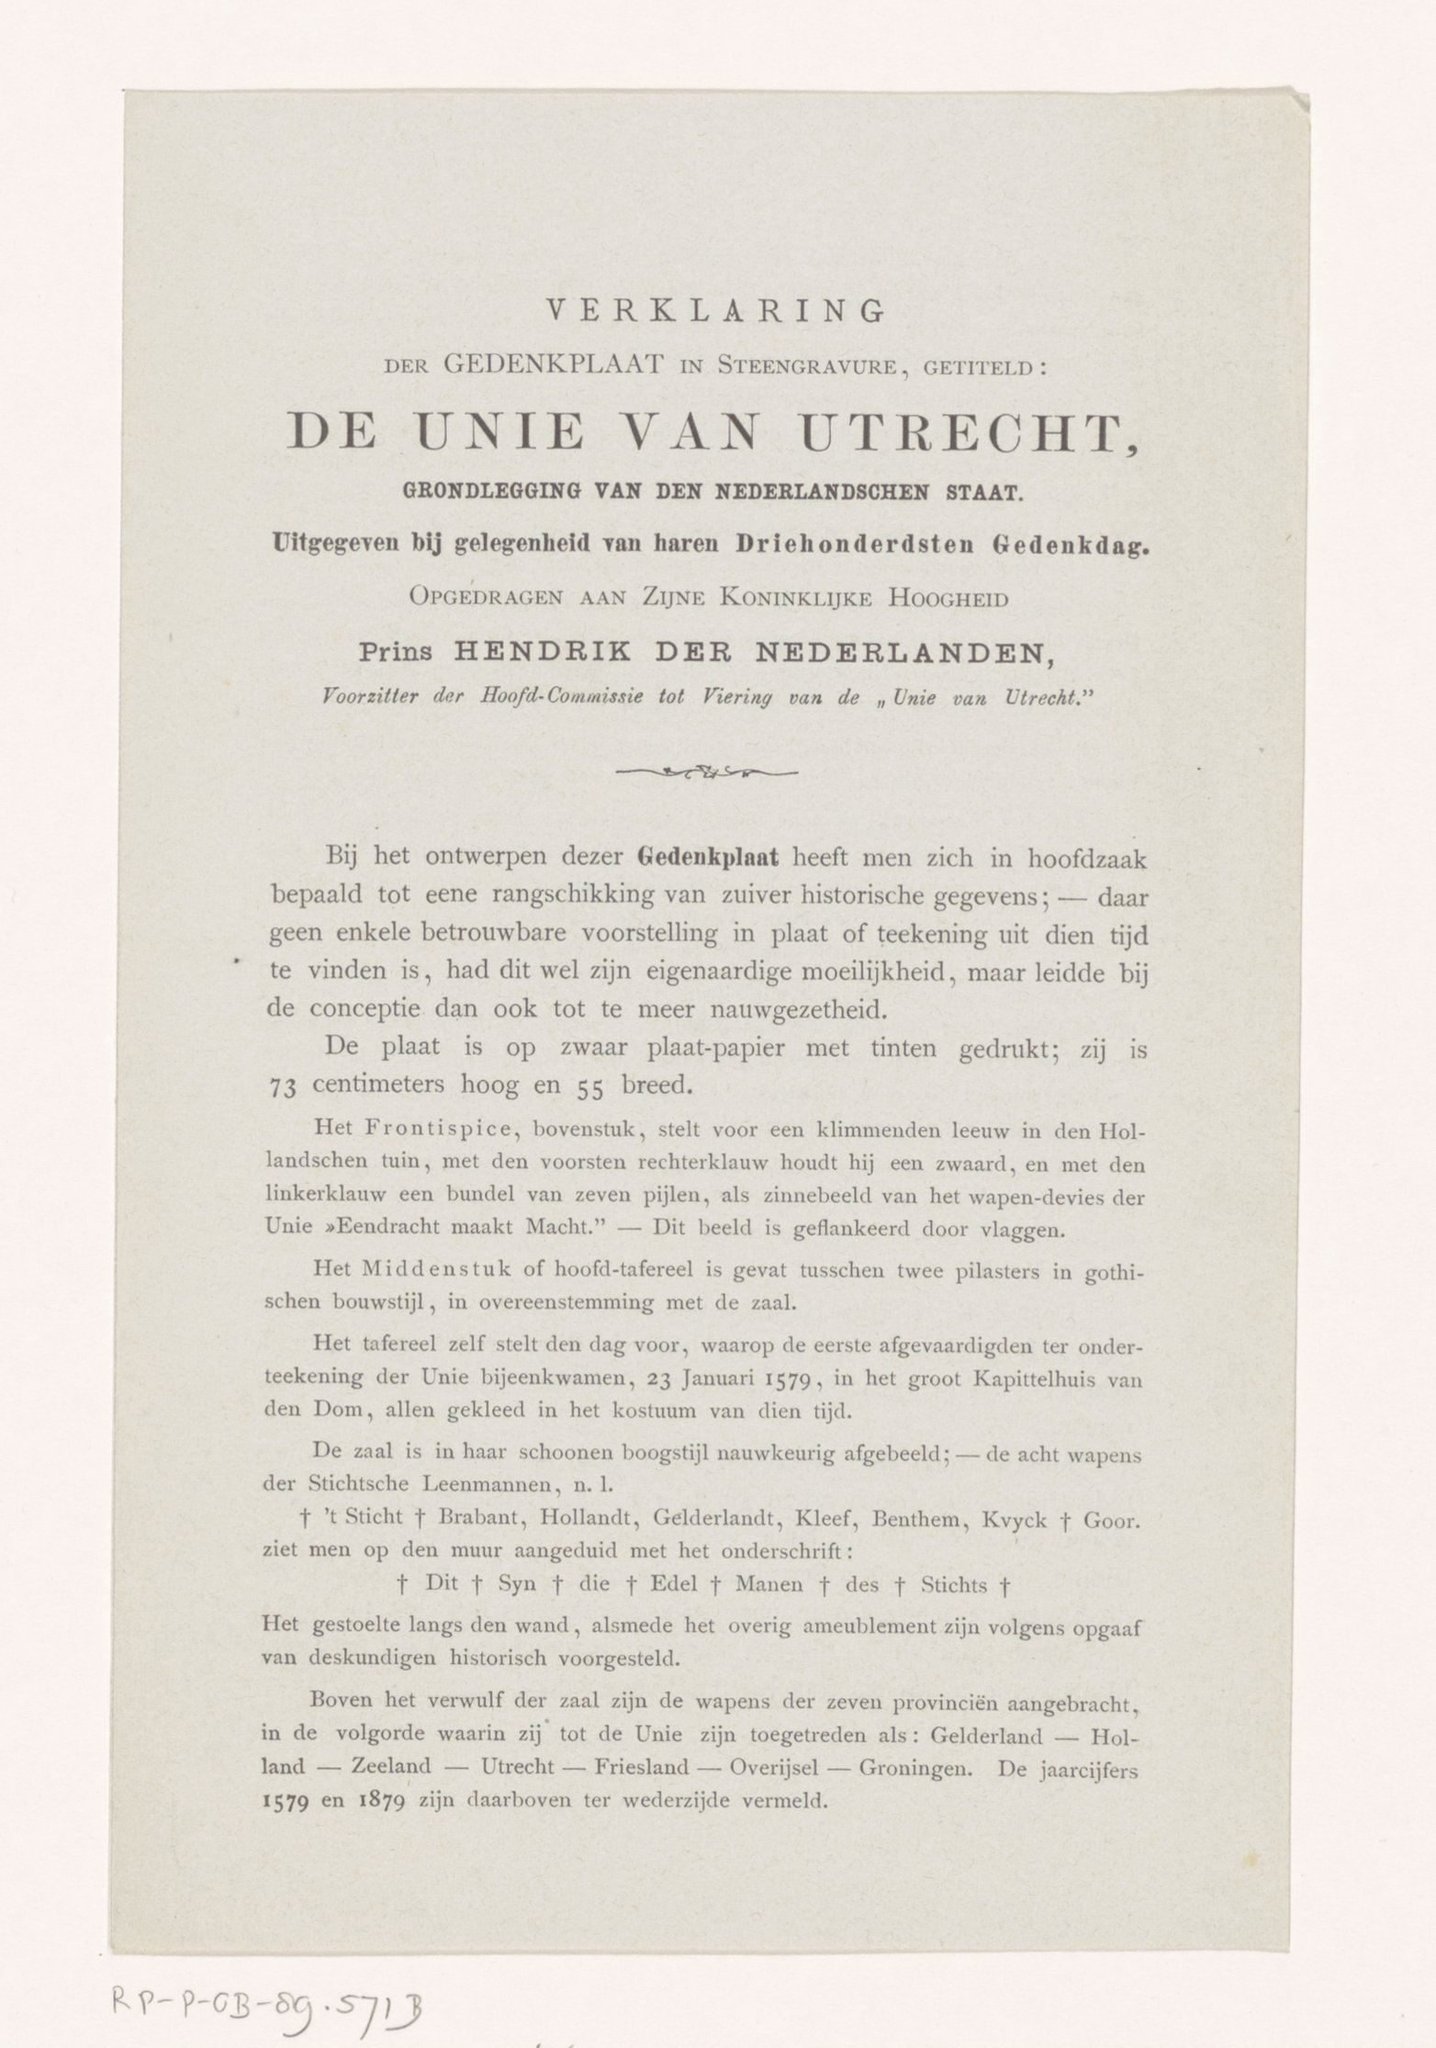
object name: text sheet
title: Verklaring bij de gedenkprent bij 300-jarige herdenking van de Unie van Utrecht 1579-1879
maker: casper van bentum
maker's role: publisher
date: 1879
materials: paper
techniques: letterpress printing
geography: utrecht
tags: alliance, league, union, foedus, union of utrecht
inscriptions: collector's mark: Lugt 2228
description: Verklaring van de voorstelling van de gedenkprent bij de 300-jarige herdenking van de Unie van Utrecht 1579 op 29 januari 1879. Dubbelgevouwen blad bedrukt op alle vier zijden.